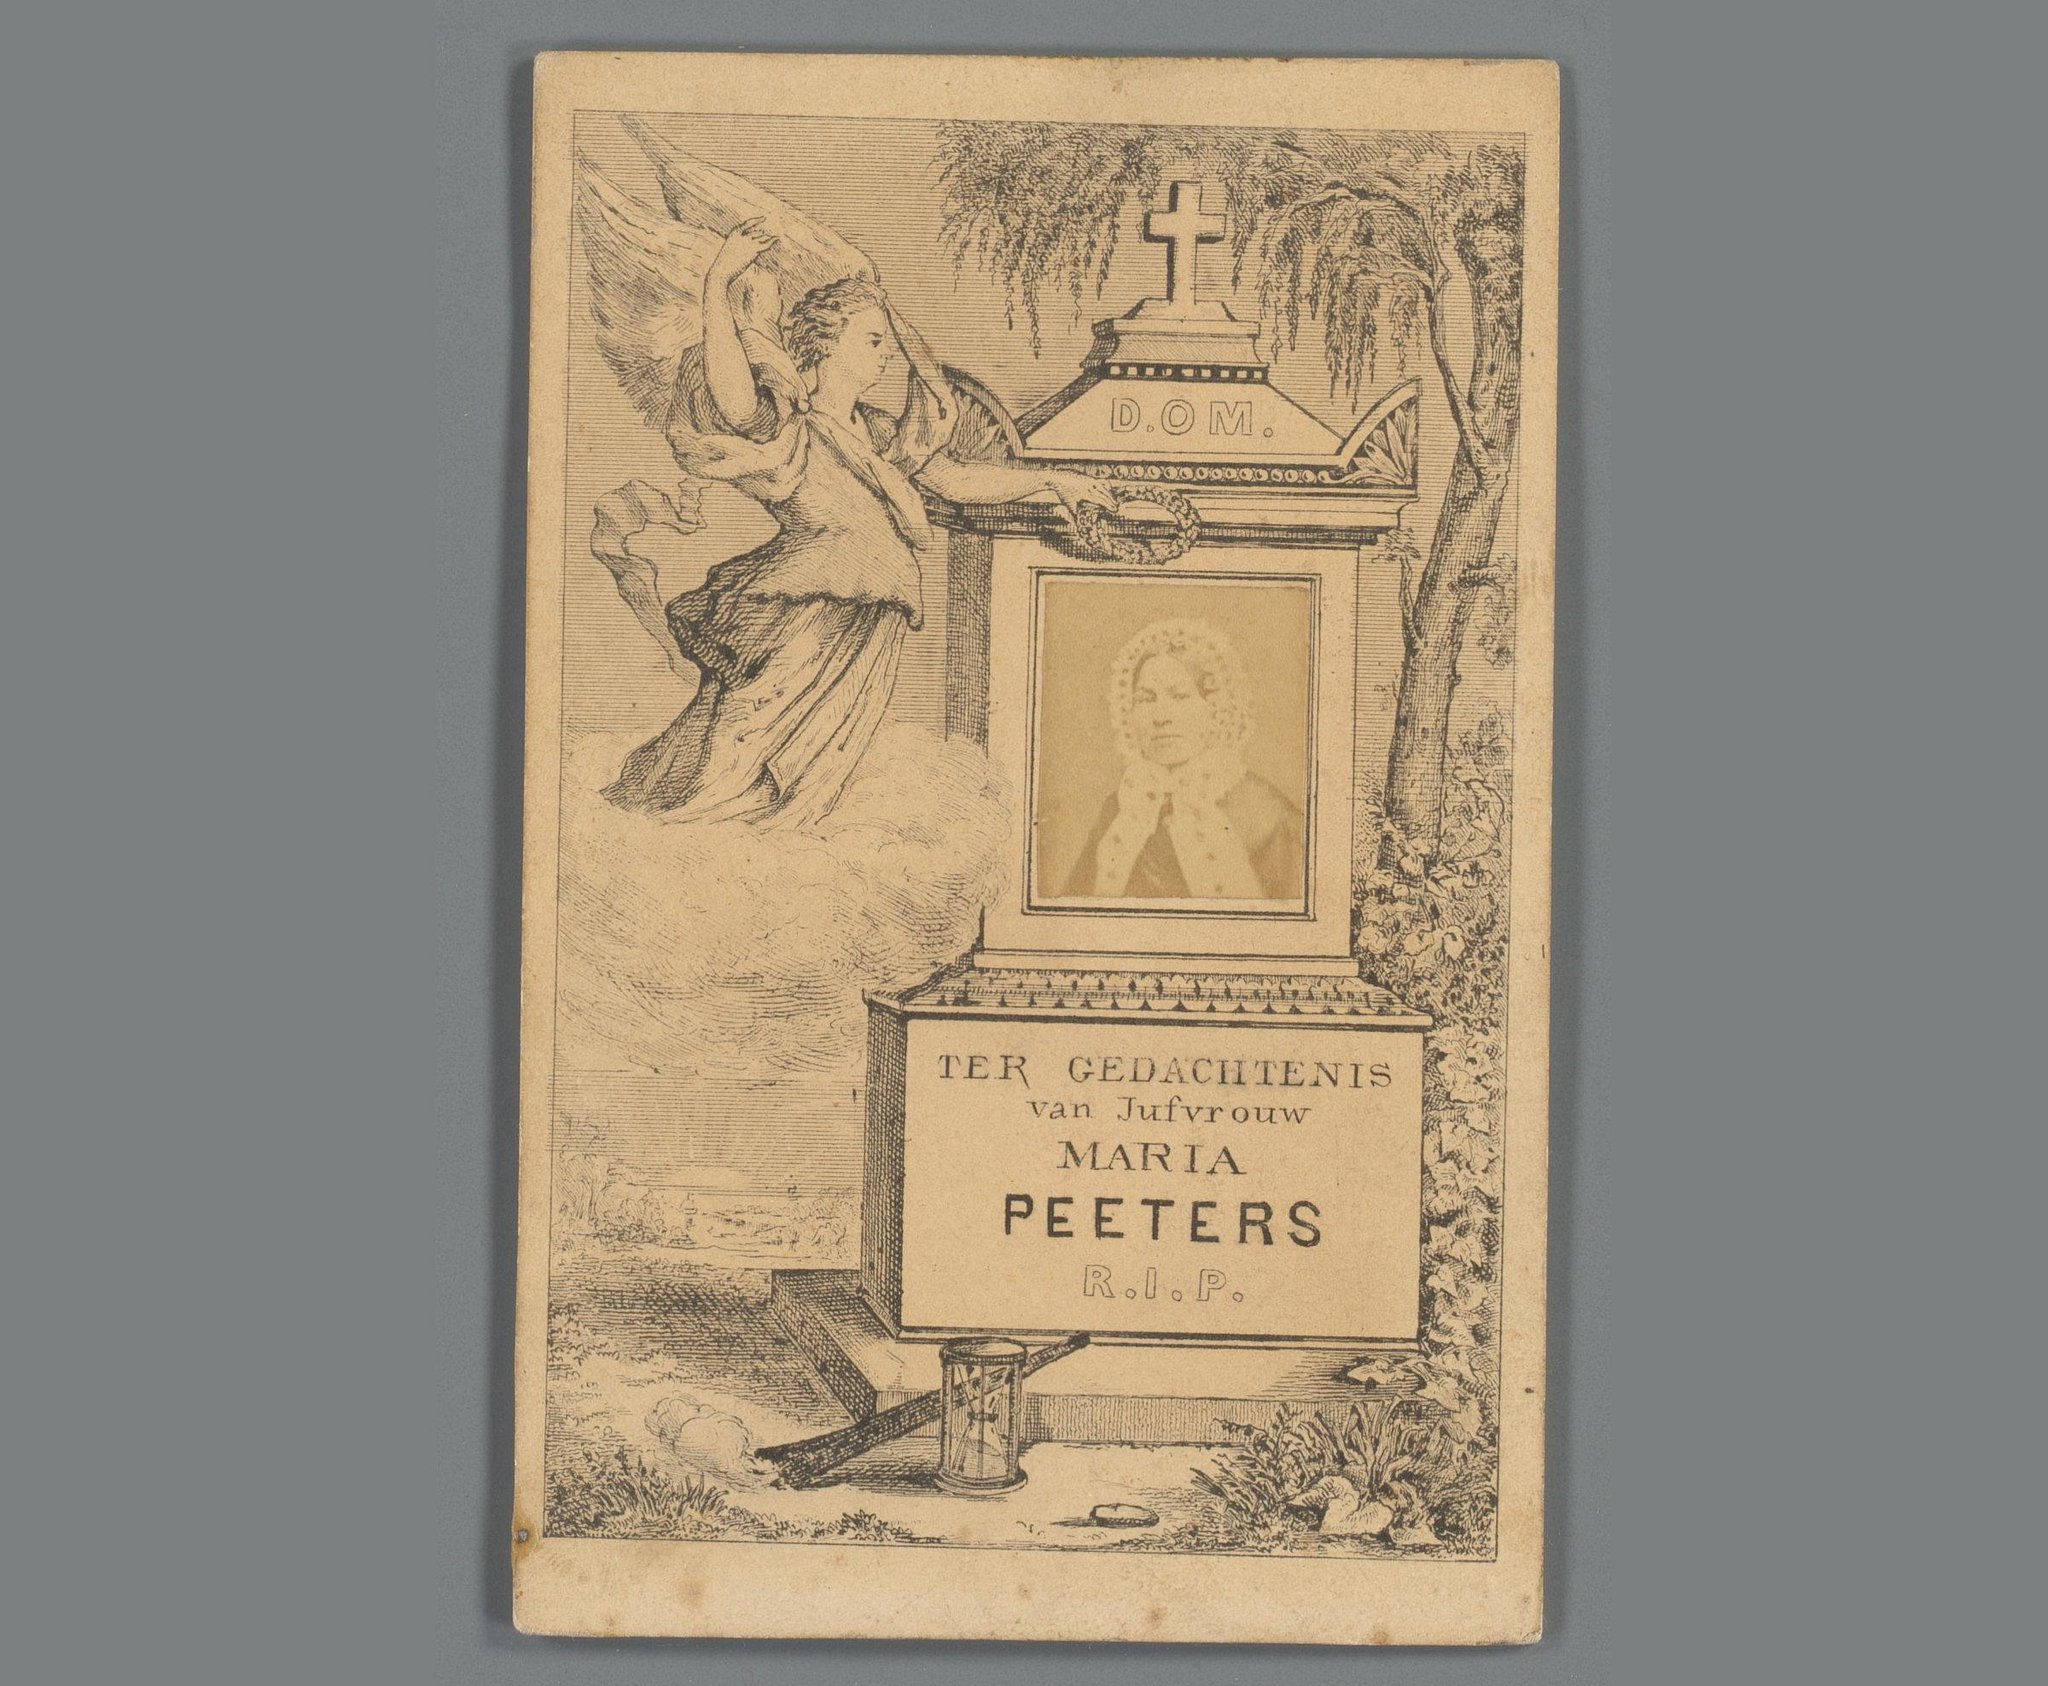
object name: print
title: Portret van Maria Peeters op een grafzerk met engel, op bidprent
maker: Anonymous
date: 1880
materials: paper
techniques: albumen print, lithograph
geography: antwerp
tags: antwerp, adult woman, historical persons, gravestone, tombstone, angels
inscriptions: inscription: ‘D.O.M./ Ter nagedachtenis/ van Jufvrouw/ Maria/ Peeters/ R.I.P.’, inscription: ‘Ik was kind van Maria, ik ben naar mijn/ moeder gegaan. (...) R.I.P./ Steendr[...]’